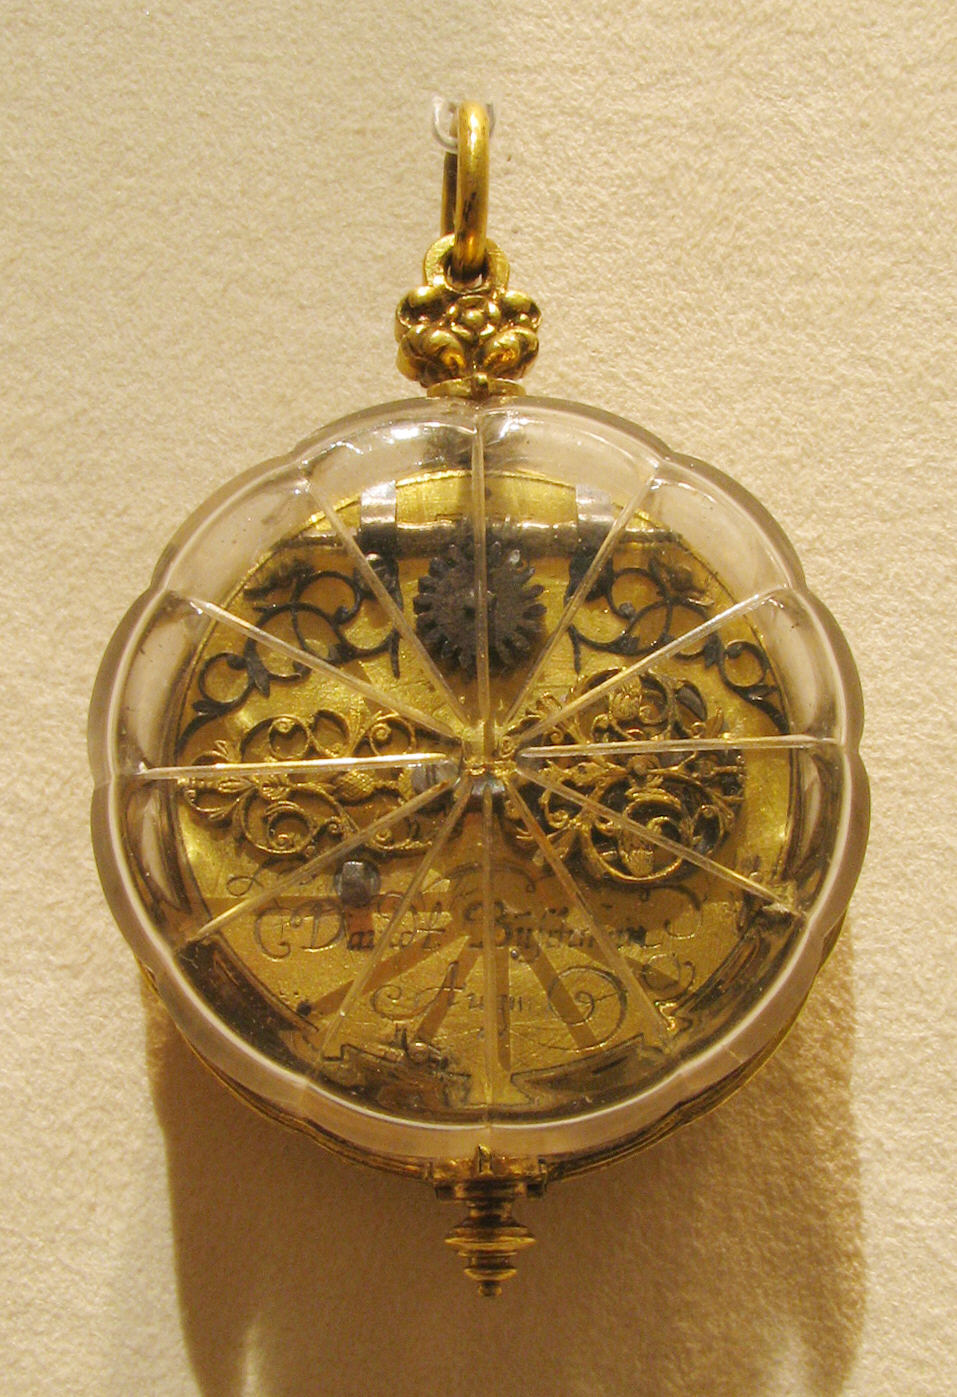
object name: watch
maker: david buschman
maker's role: maker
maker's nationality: german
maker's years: 1626-1701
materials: gilt brass, gilt, quartz, silver, steel